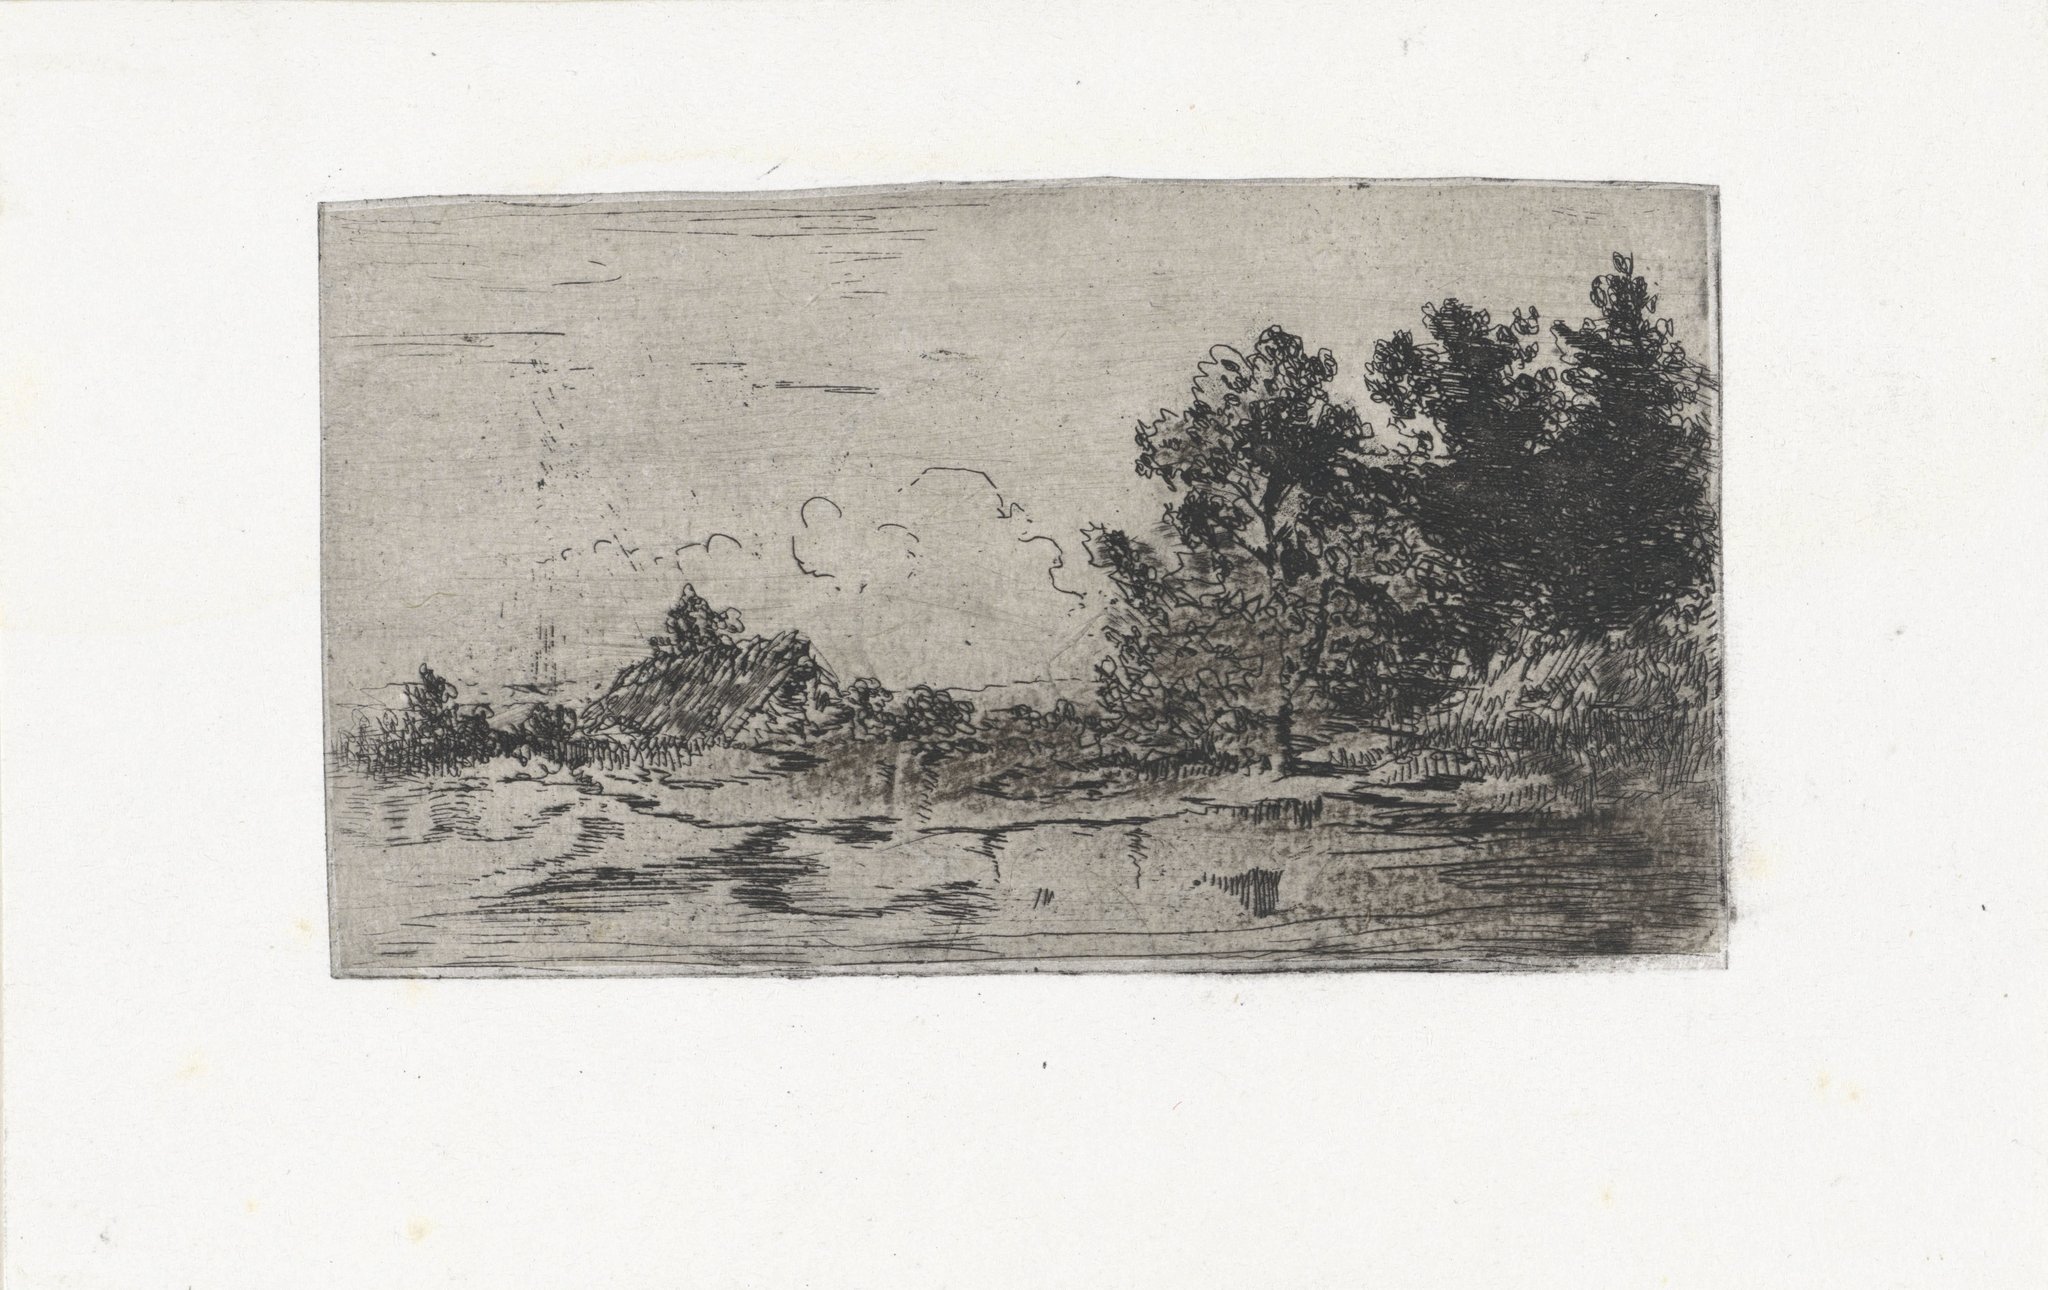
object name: print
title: Rietgedekte hut aan het water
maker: arnoud schaepkens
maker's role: print maker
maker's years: 1816-1904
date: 1831-1904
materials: paper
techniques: drypoint, etching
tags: landscapes with waters, waterscapes, seascapes (in the temperate zone), cottage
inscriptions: collector's mark: Lugt 2228